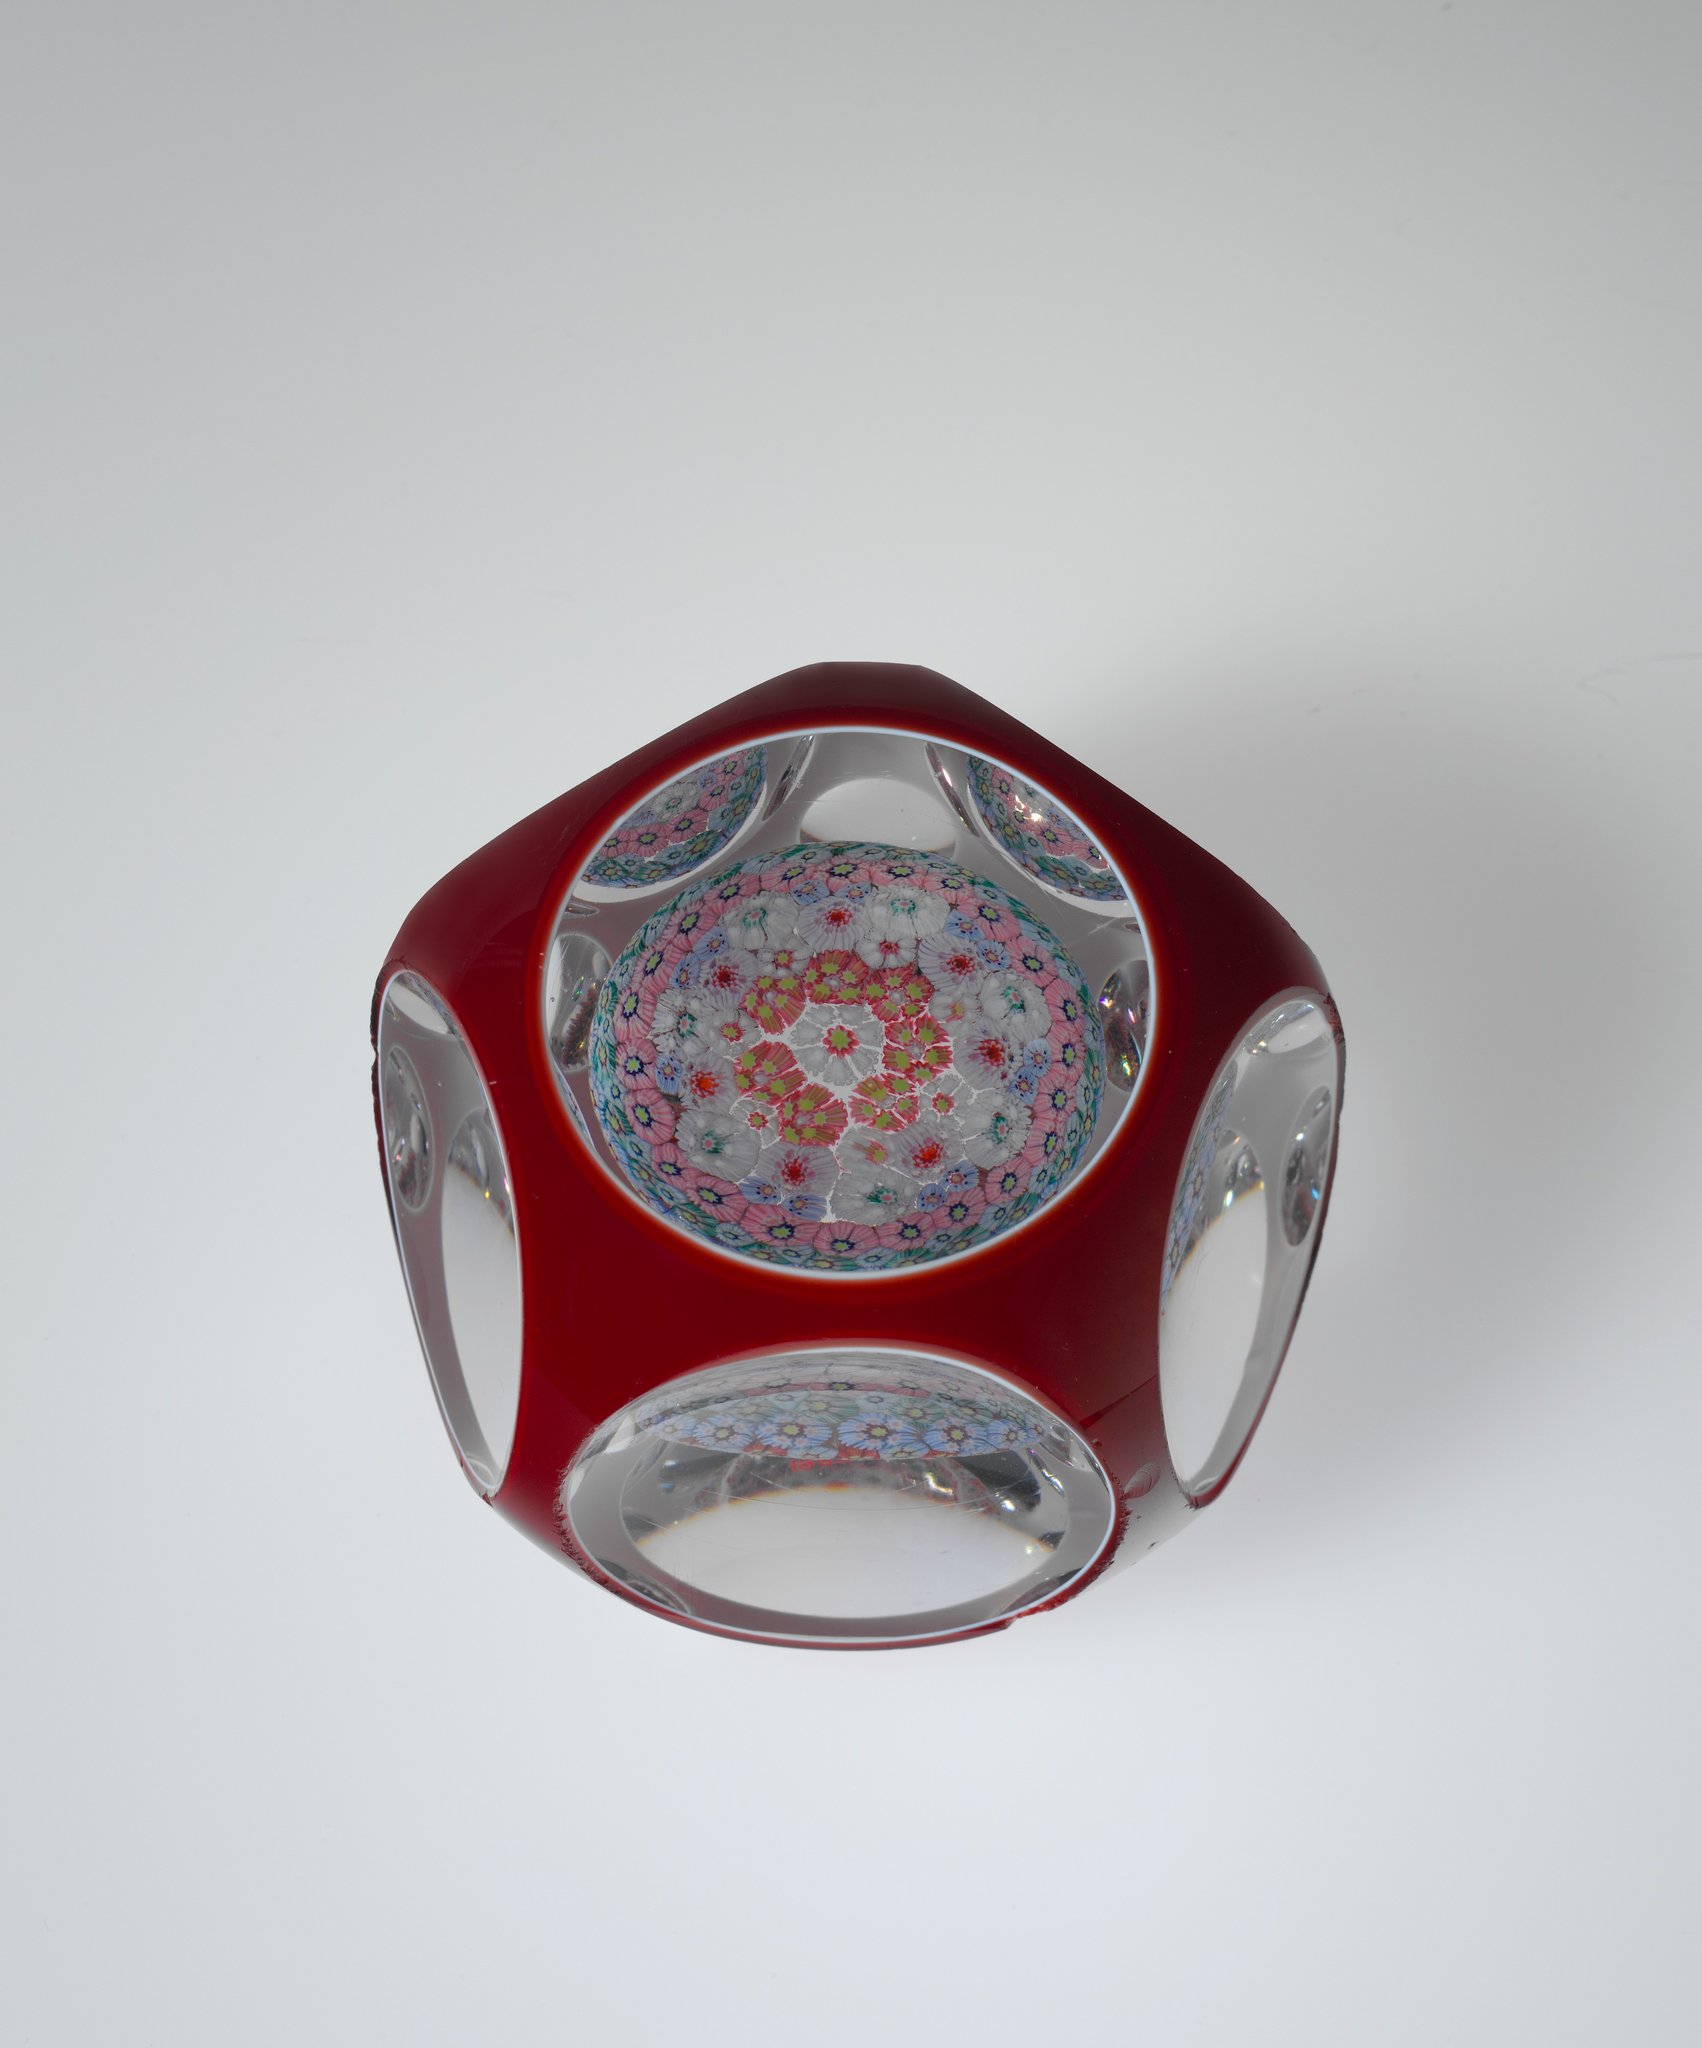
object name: paperweight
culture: american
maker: william leighton sr.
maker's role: designer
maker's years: 1808-1891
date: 1850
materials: glass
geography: united states